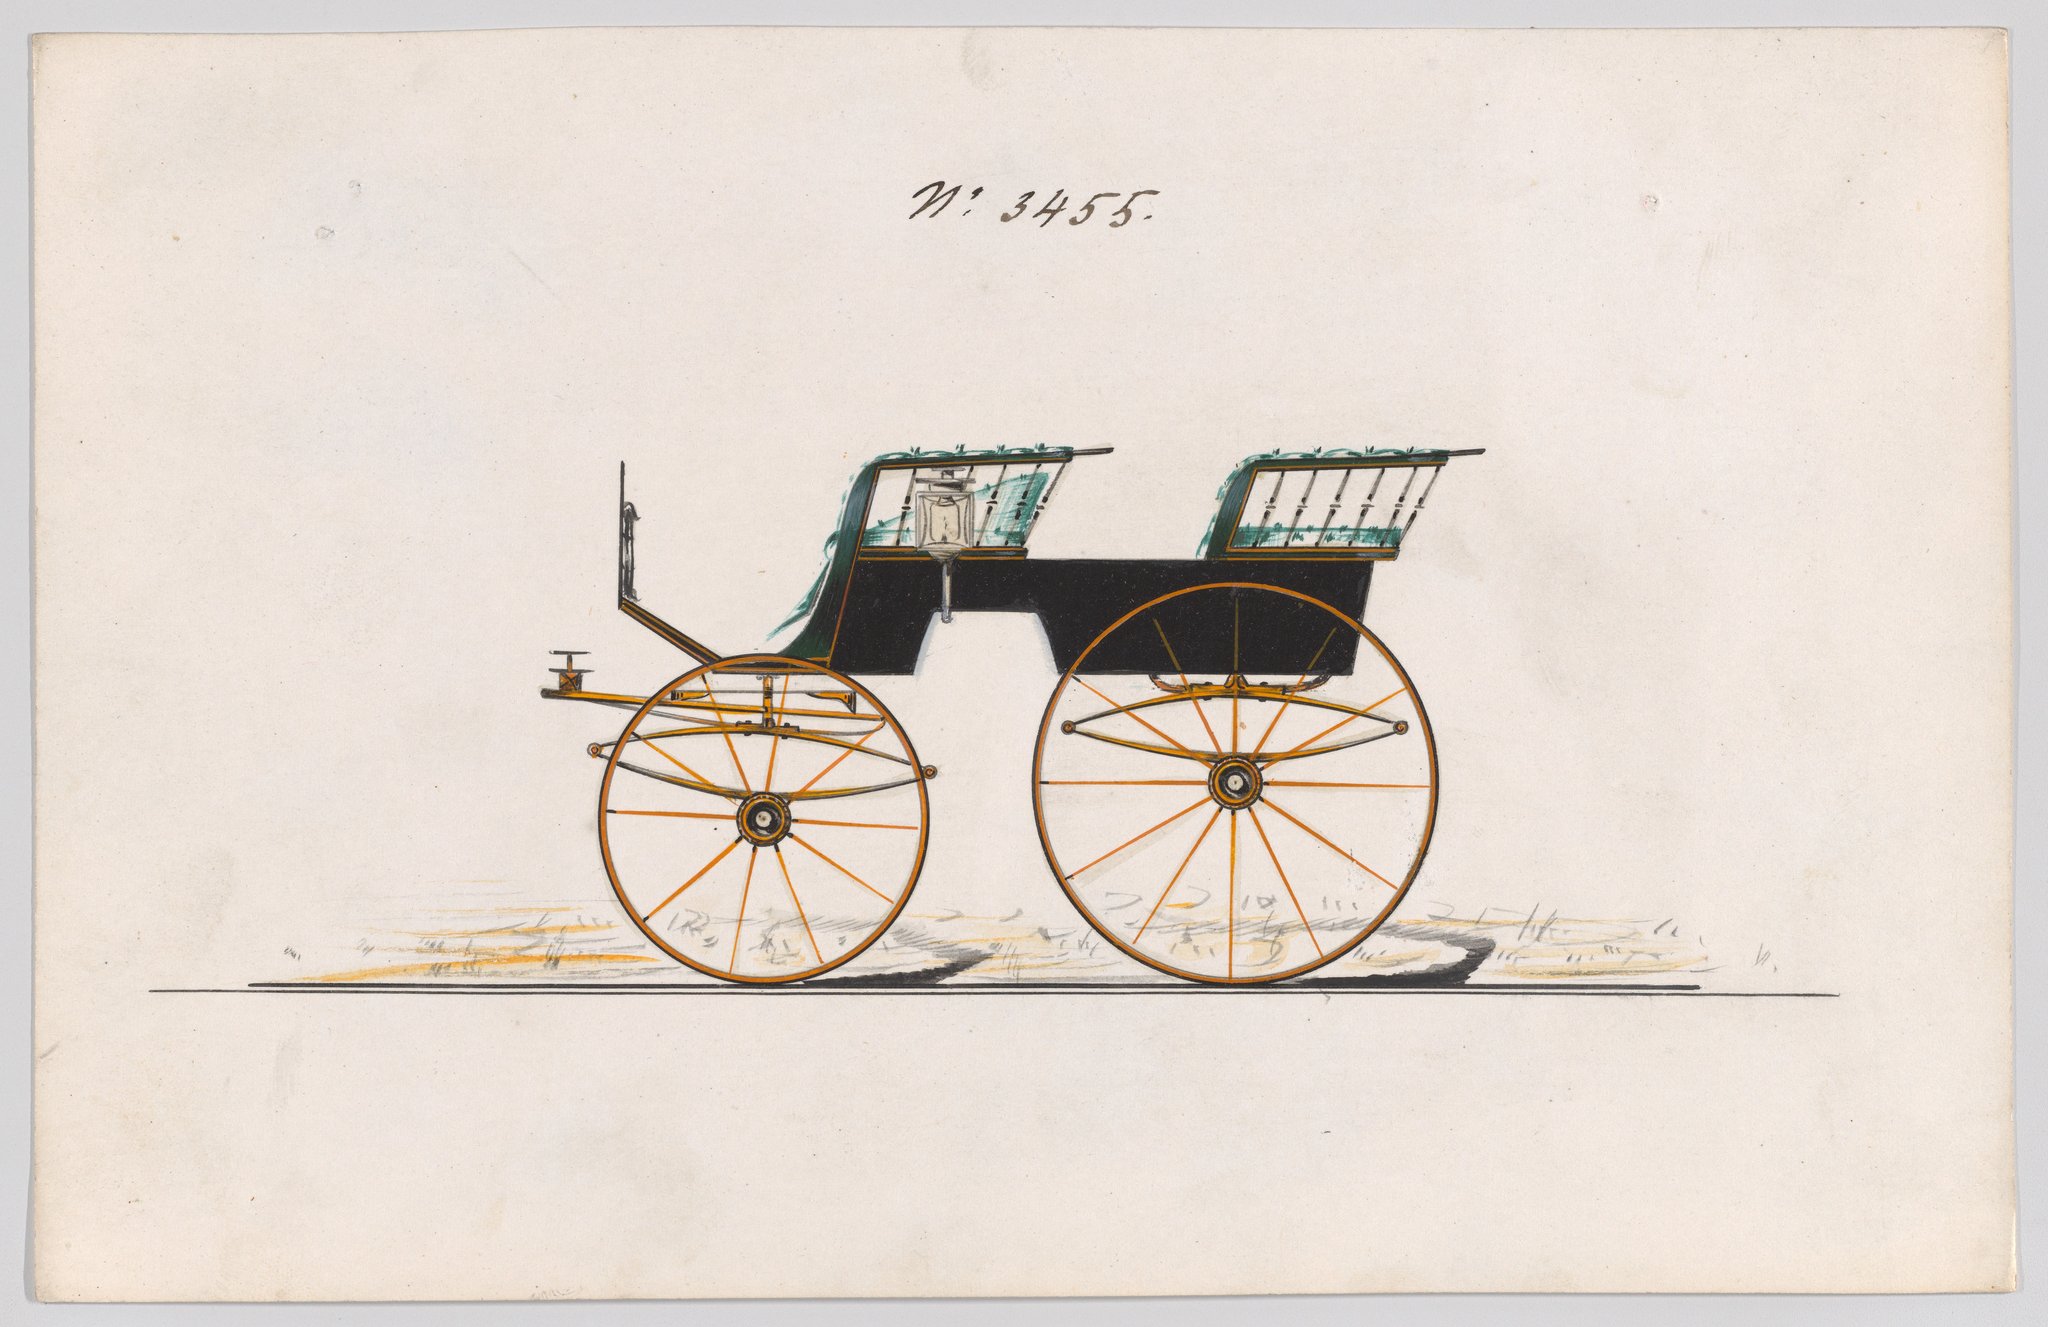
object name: drawing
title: Design for T-Cart, no. 3455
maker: brewster & co.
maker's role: manufacturer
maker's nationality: american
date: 1878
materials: gouache, gum arabic, ink, watercolor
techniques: pen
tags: carriages